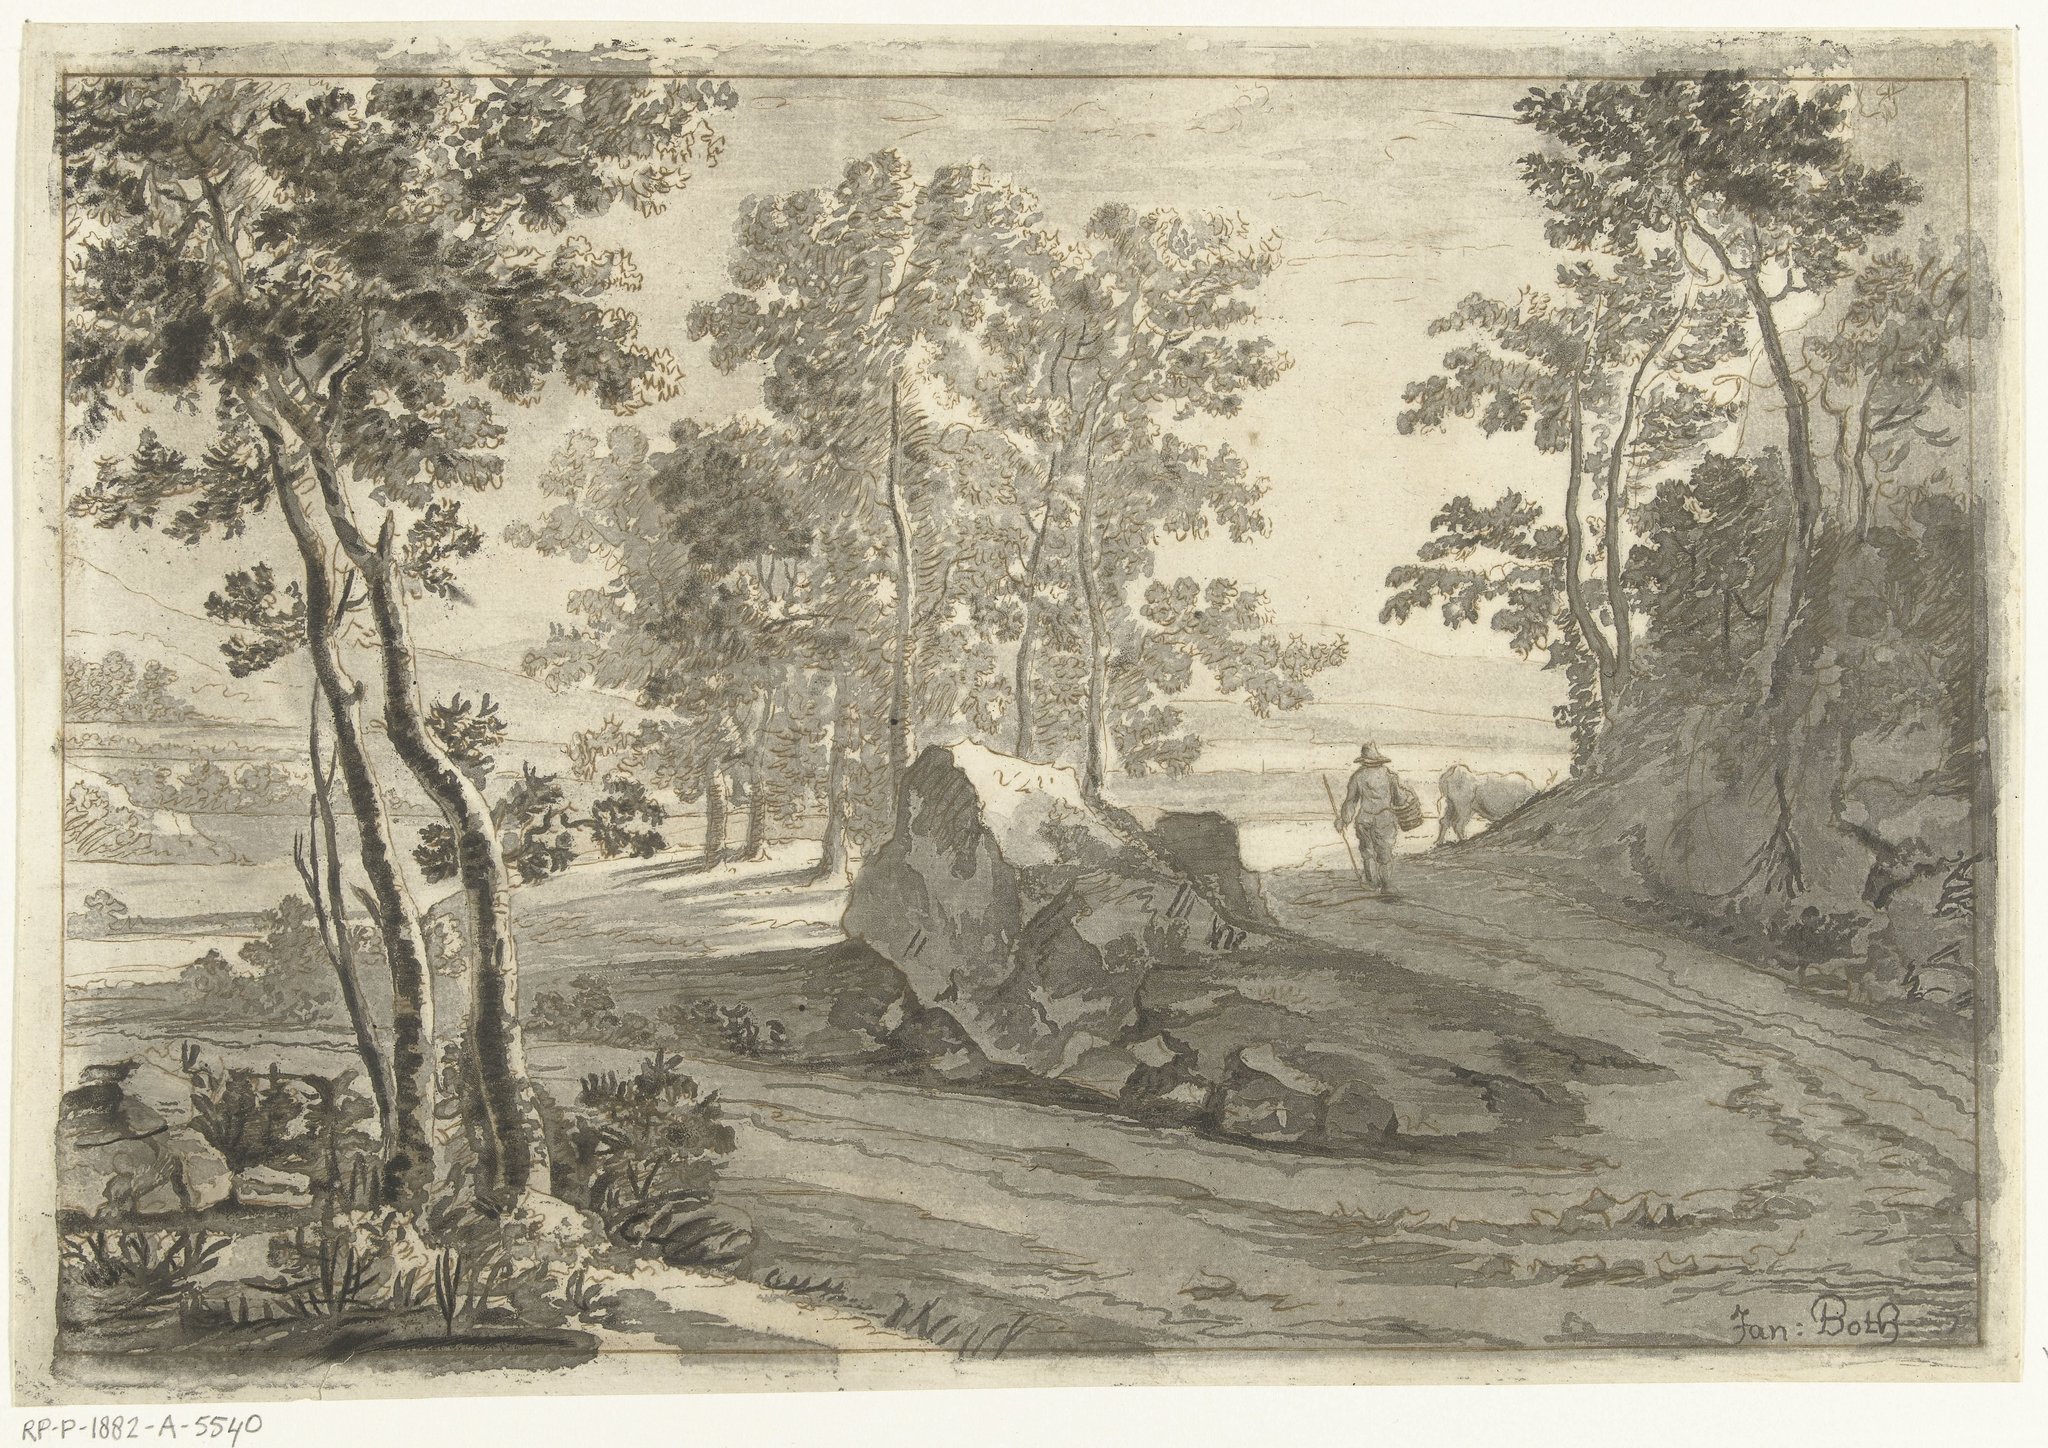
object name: print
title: Boomrijk landschap met veedrijver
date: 1741-1803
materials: paper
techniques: aquatint, etching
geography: netherlands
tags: low hill country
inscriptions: collector's mark: Lugt 2228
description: Prent naar tekening van Jan Both gedrukt met twee platen. Prent uit serie van negen prenttekeningen met acht landschappen en een zeegezicht naar Hollandse meesters uit de 17e eeuw. Cornelis Brouwer heeft in samenwerking met C.S. Roos een aantal prenttekeningen uitgegeven welke op het verso het signatuur C.Brouwer fecit en C.S. Roos excudit Amst. dragen, zie Huffel 1921, p. 33-35. Op dit exemplaar ontbreekt de handgeschreven signatuur van Roos.